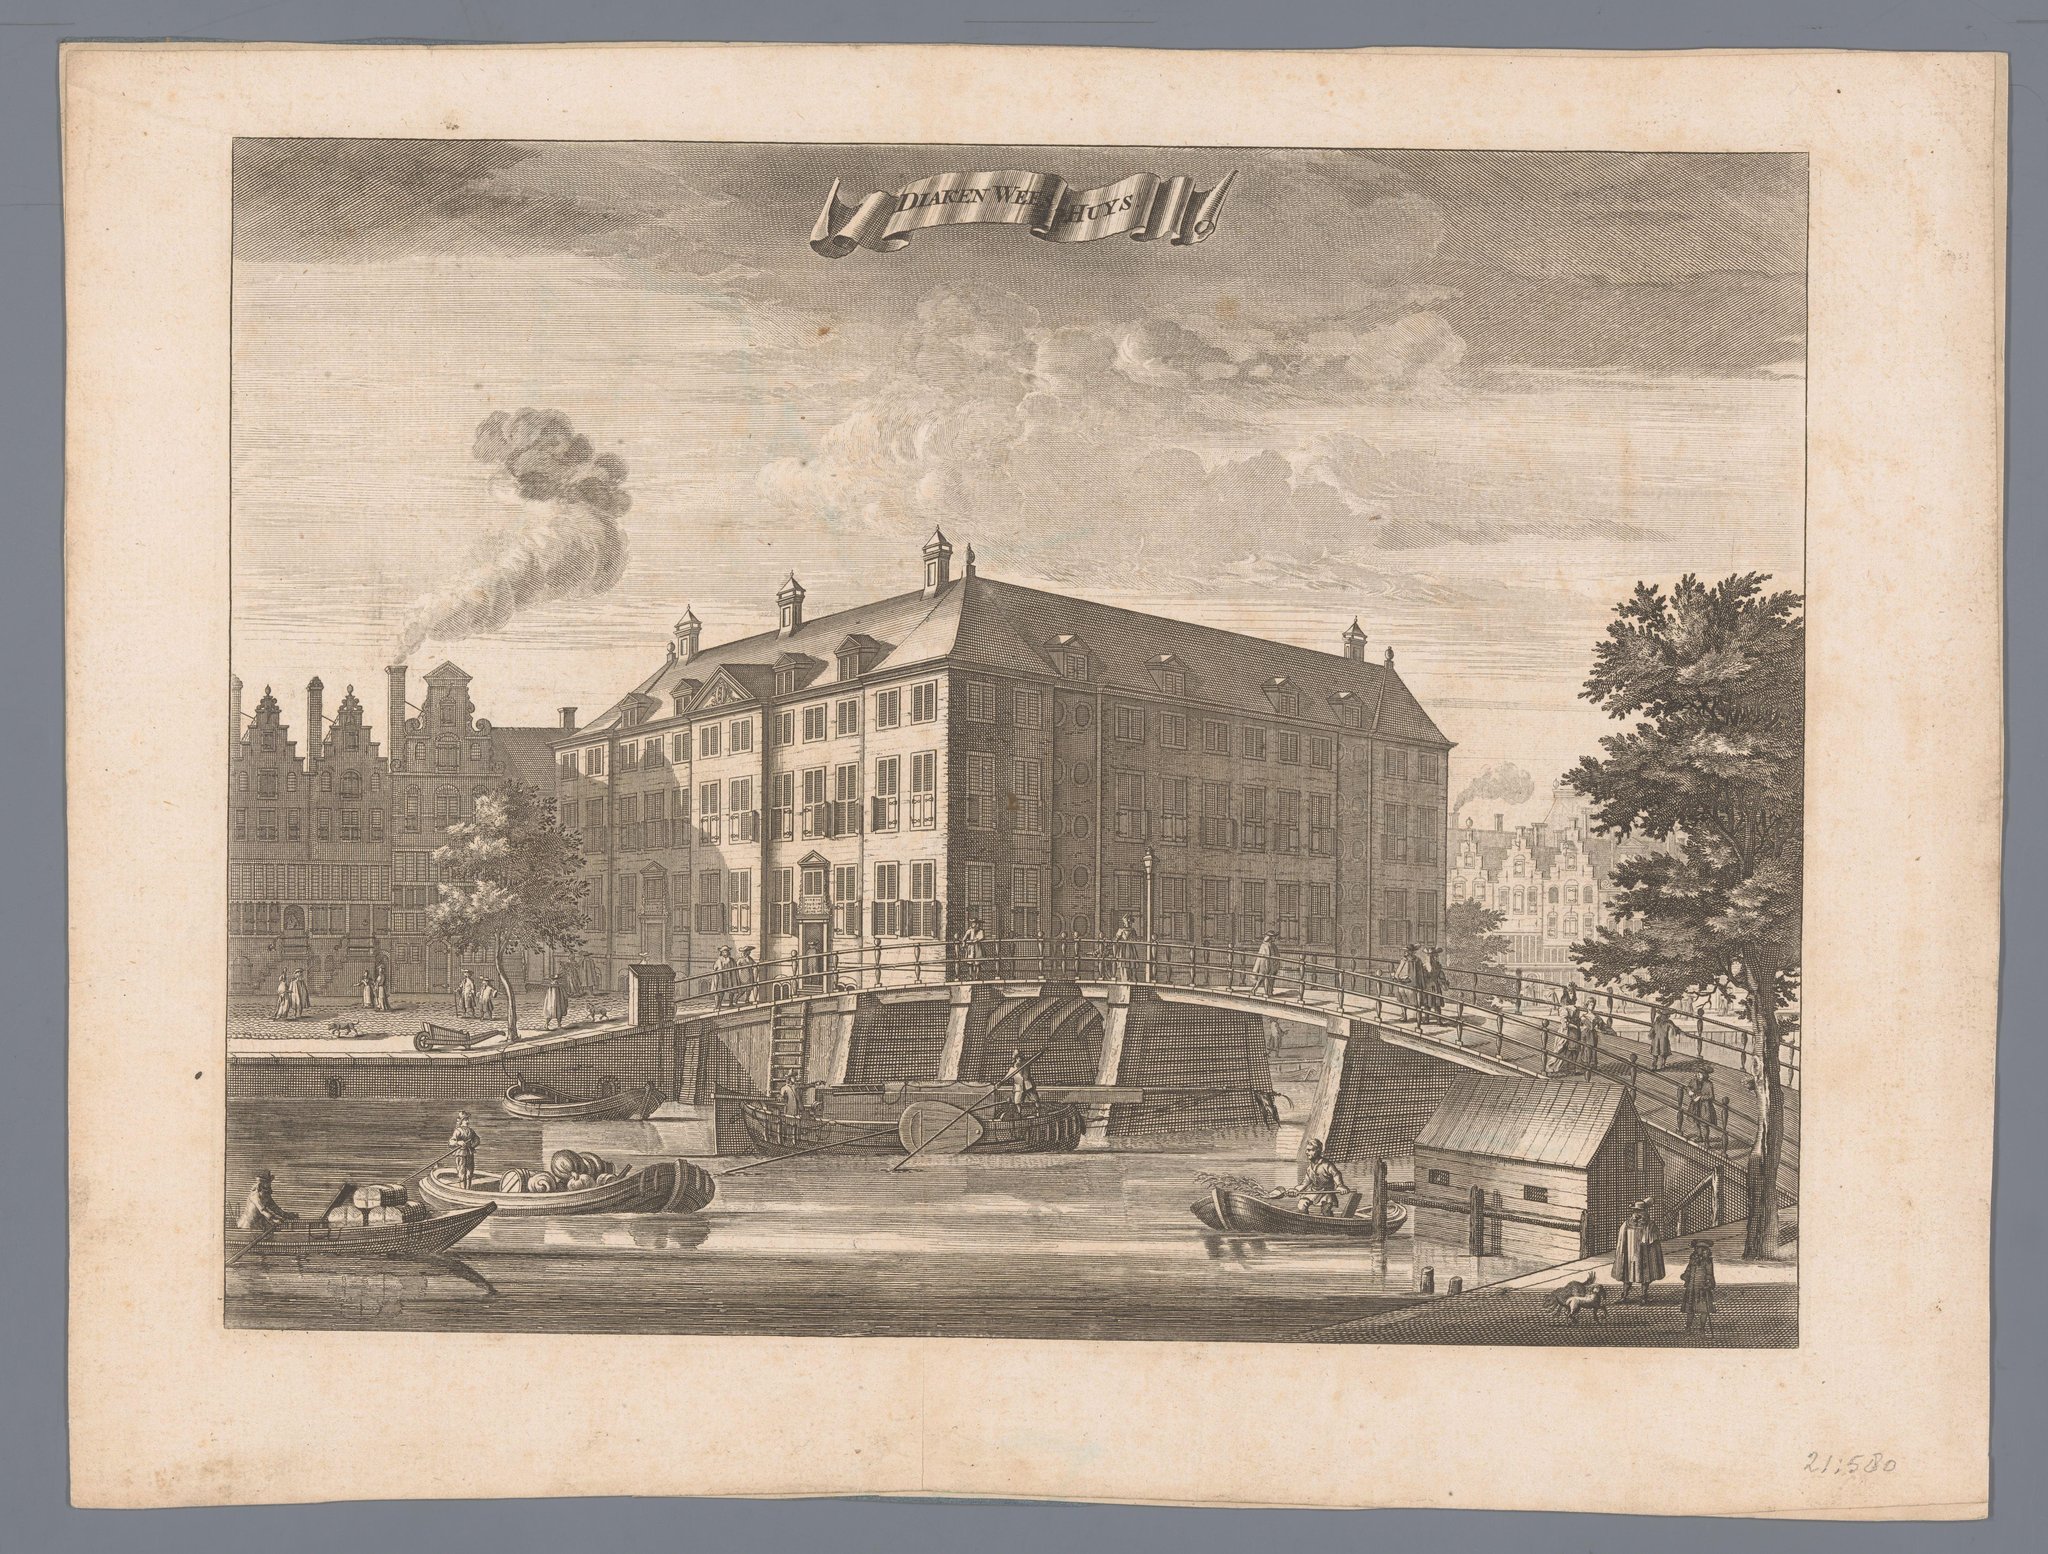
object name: print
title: Diaken Wees-huys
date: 1693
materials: paper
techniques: engraving, etching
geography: amsterdam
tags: poling, punting, bridge in city across river, canal, etc.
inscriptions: collector's mark: Lugt 2233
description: Prent uit: Commelin, Caspar. Beschryvinge van Amsterdam (...). 2 dln. Amsterdam: Weduwe Dircksz. Oossaan, 1693, dl. 2, p. 594.